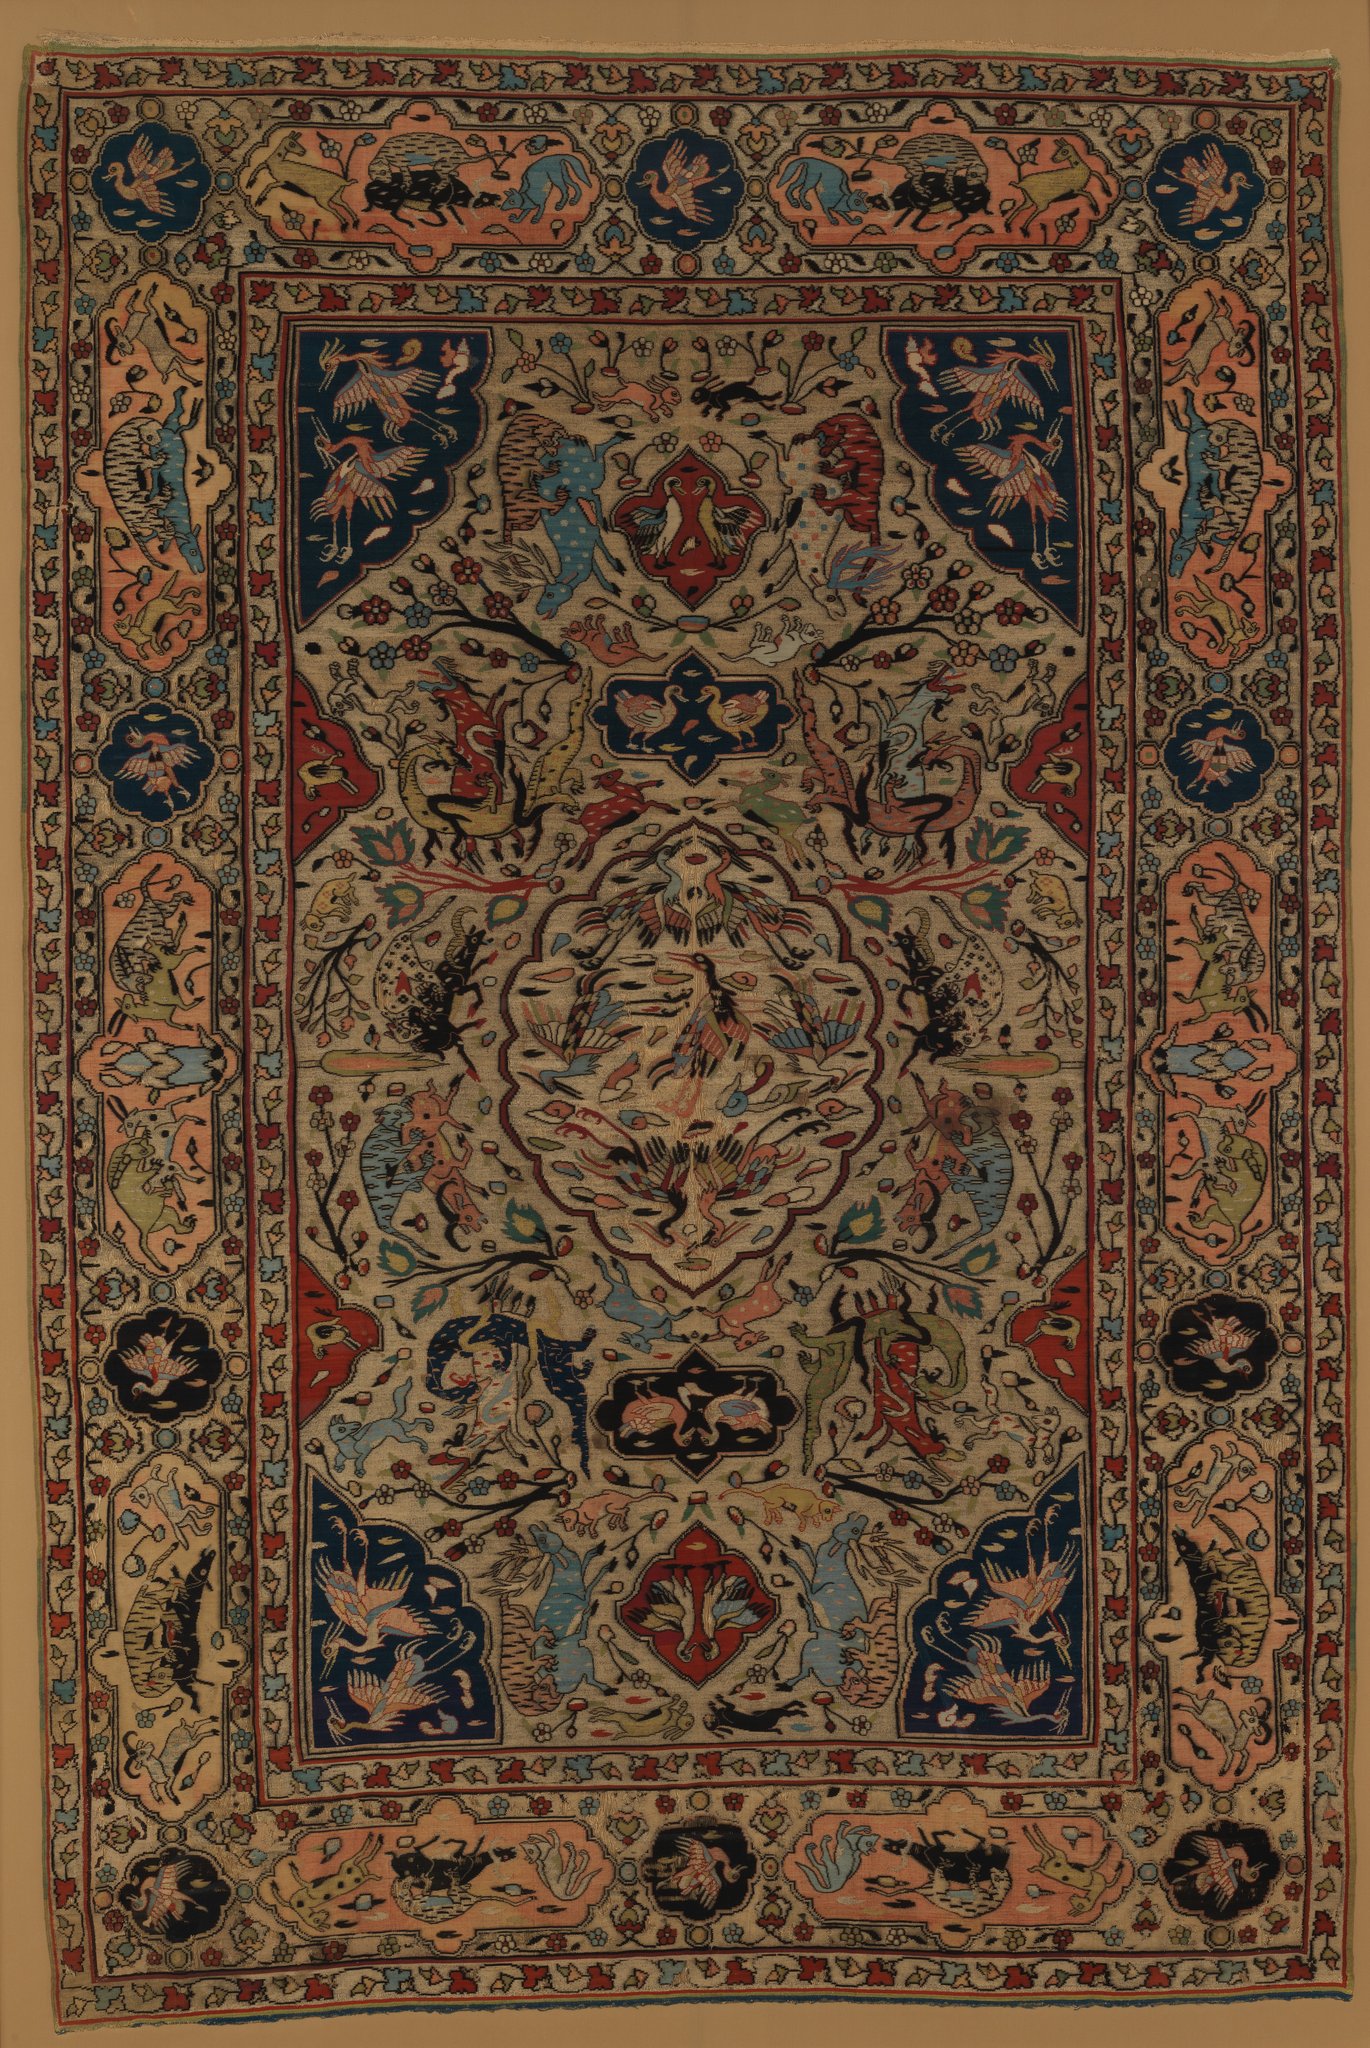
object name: carpet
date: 1567-1633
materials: metal thread, silk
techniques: weave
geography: iran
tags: animals,birds